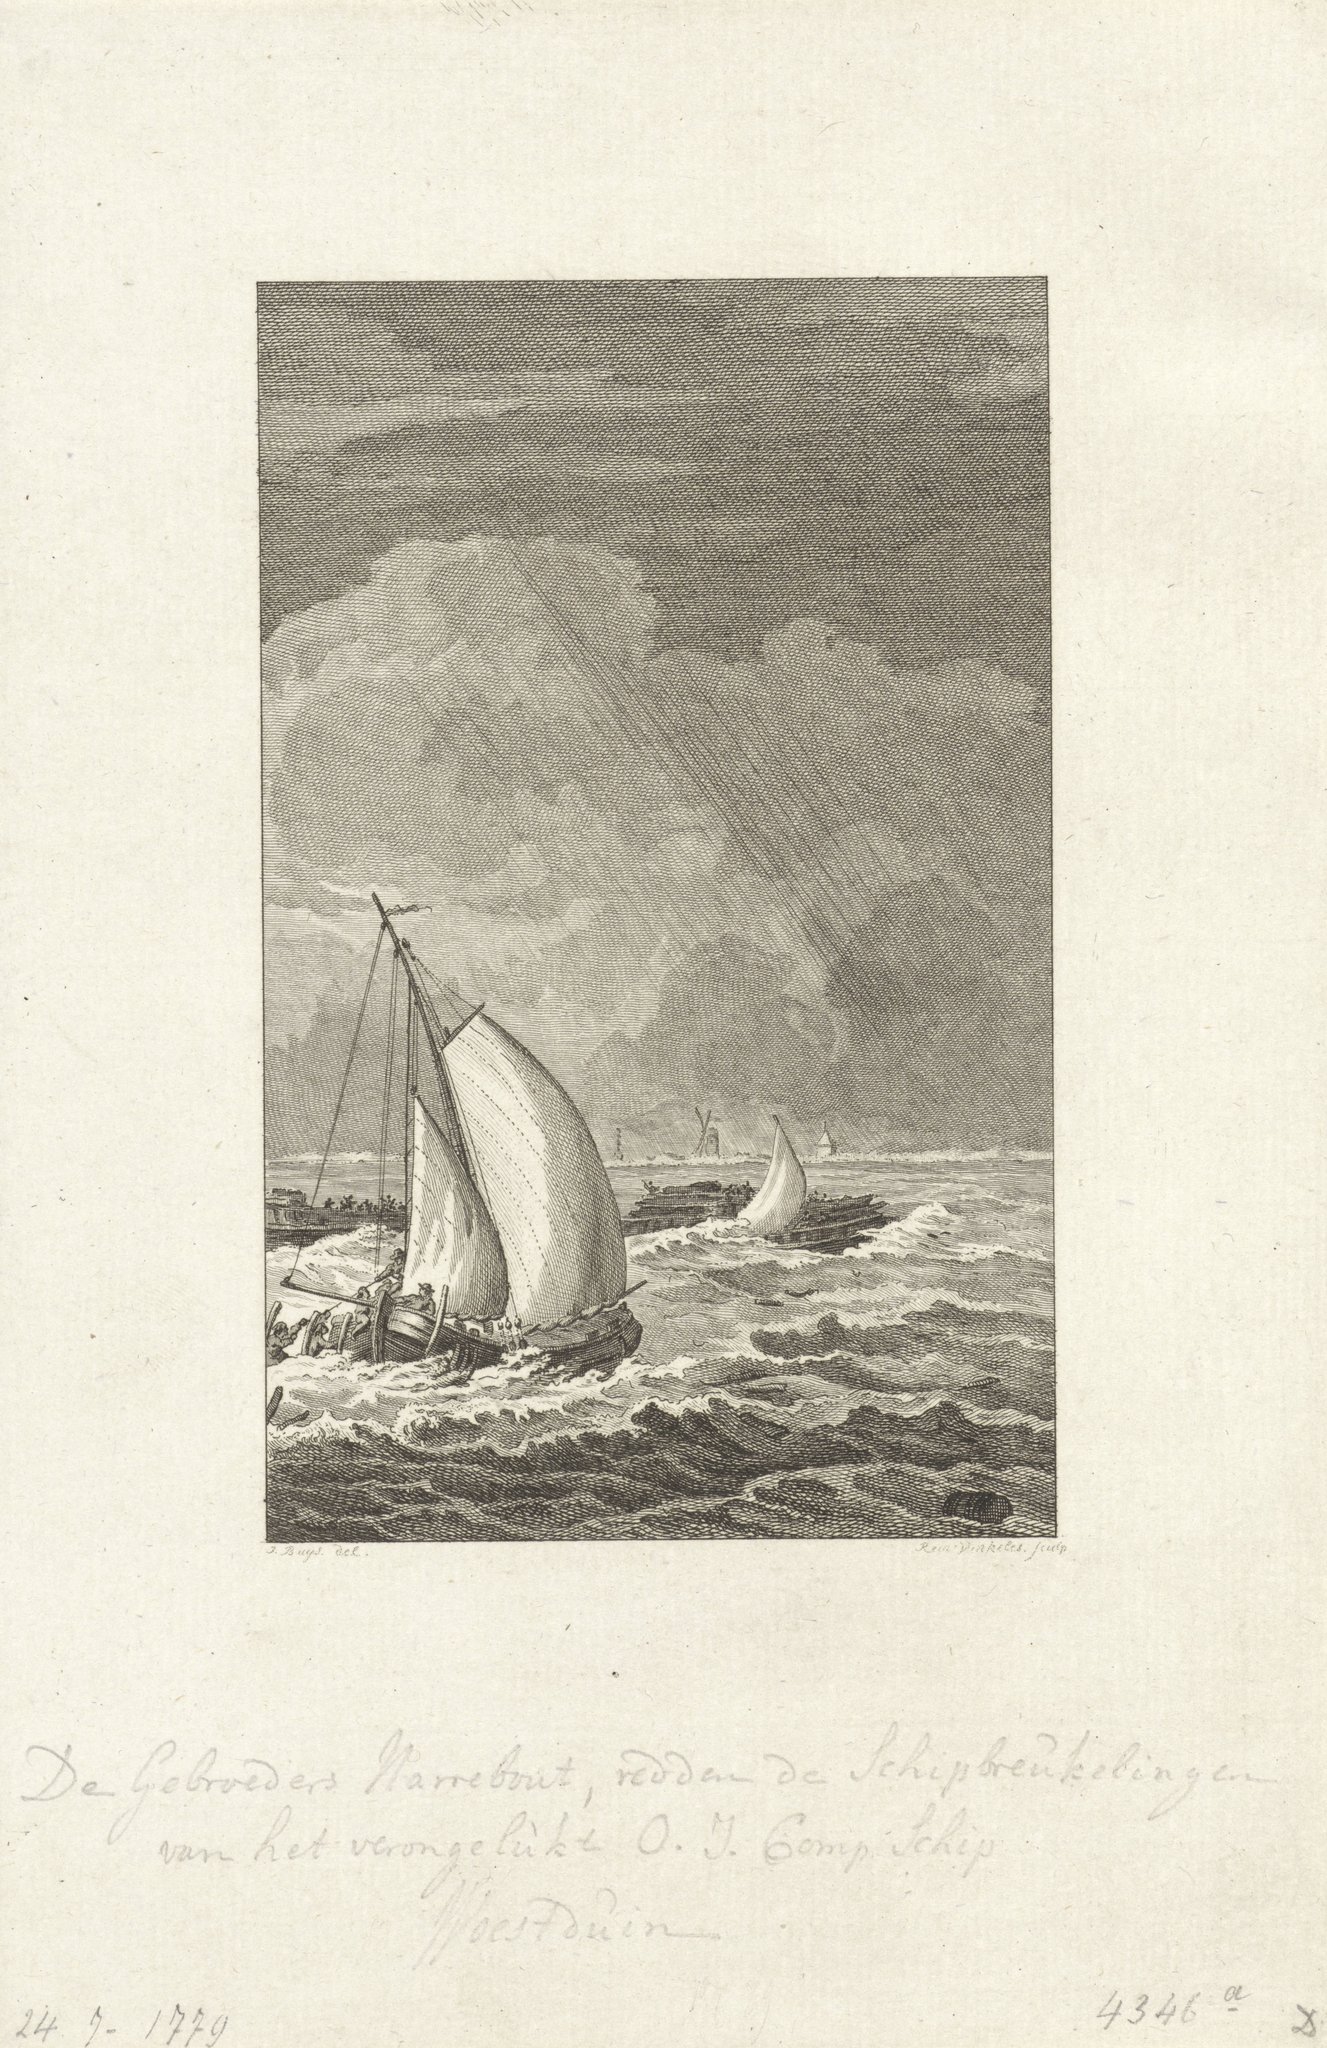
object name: print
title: Gebroeders Naerebout redden de opvarenden van de Woestduin, 1779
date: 1787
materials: paper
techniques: engraving, etching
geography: amsterdam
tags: shipwreck (+ saving the victims ~ traffic accident), storm at sea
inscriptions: collector's mark: Lugt 240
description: Gebruikt als illustratie in: P.A. Loosjes. Vaderlandsche historie, vervattende de geschiedenissen, der Vereenigde Nederlanden (...). Ten onmiddelyken vervolge van Wagenaar's Vaderlandsche historie. Amsterdam: J. Allart.